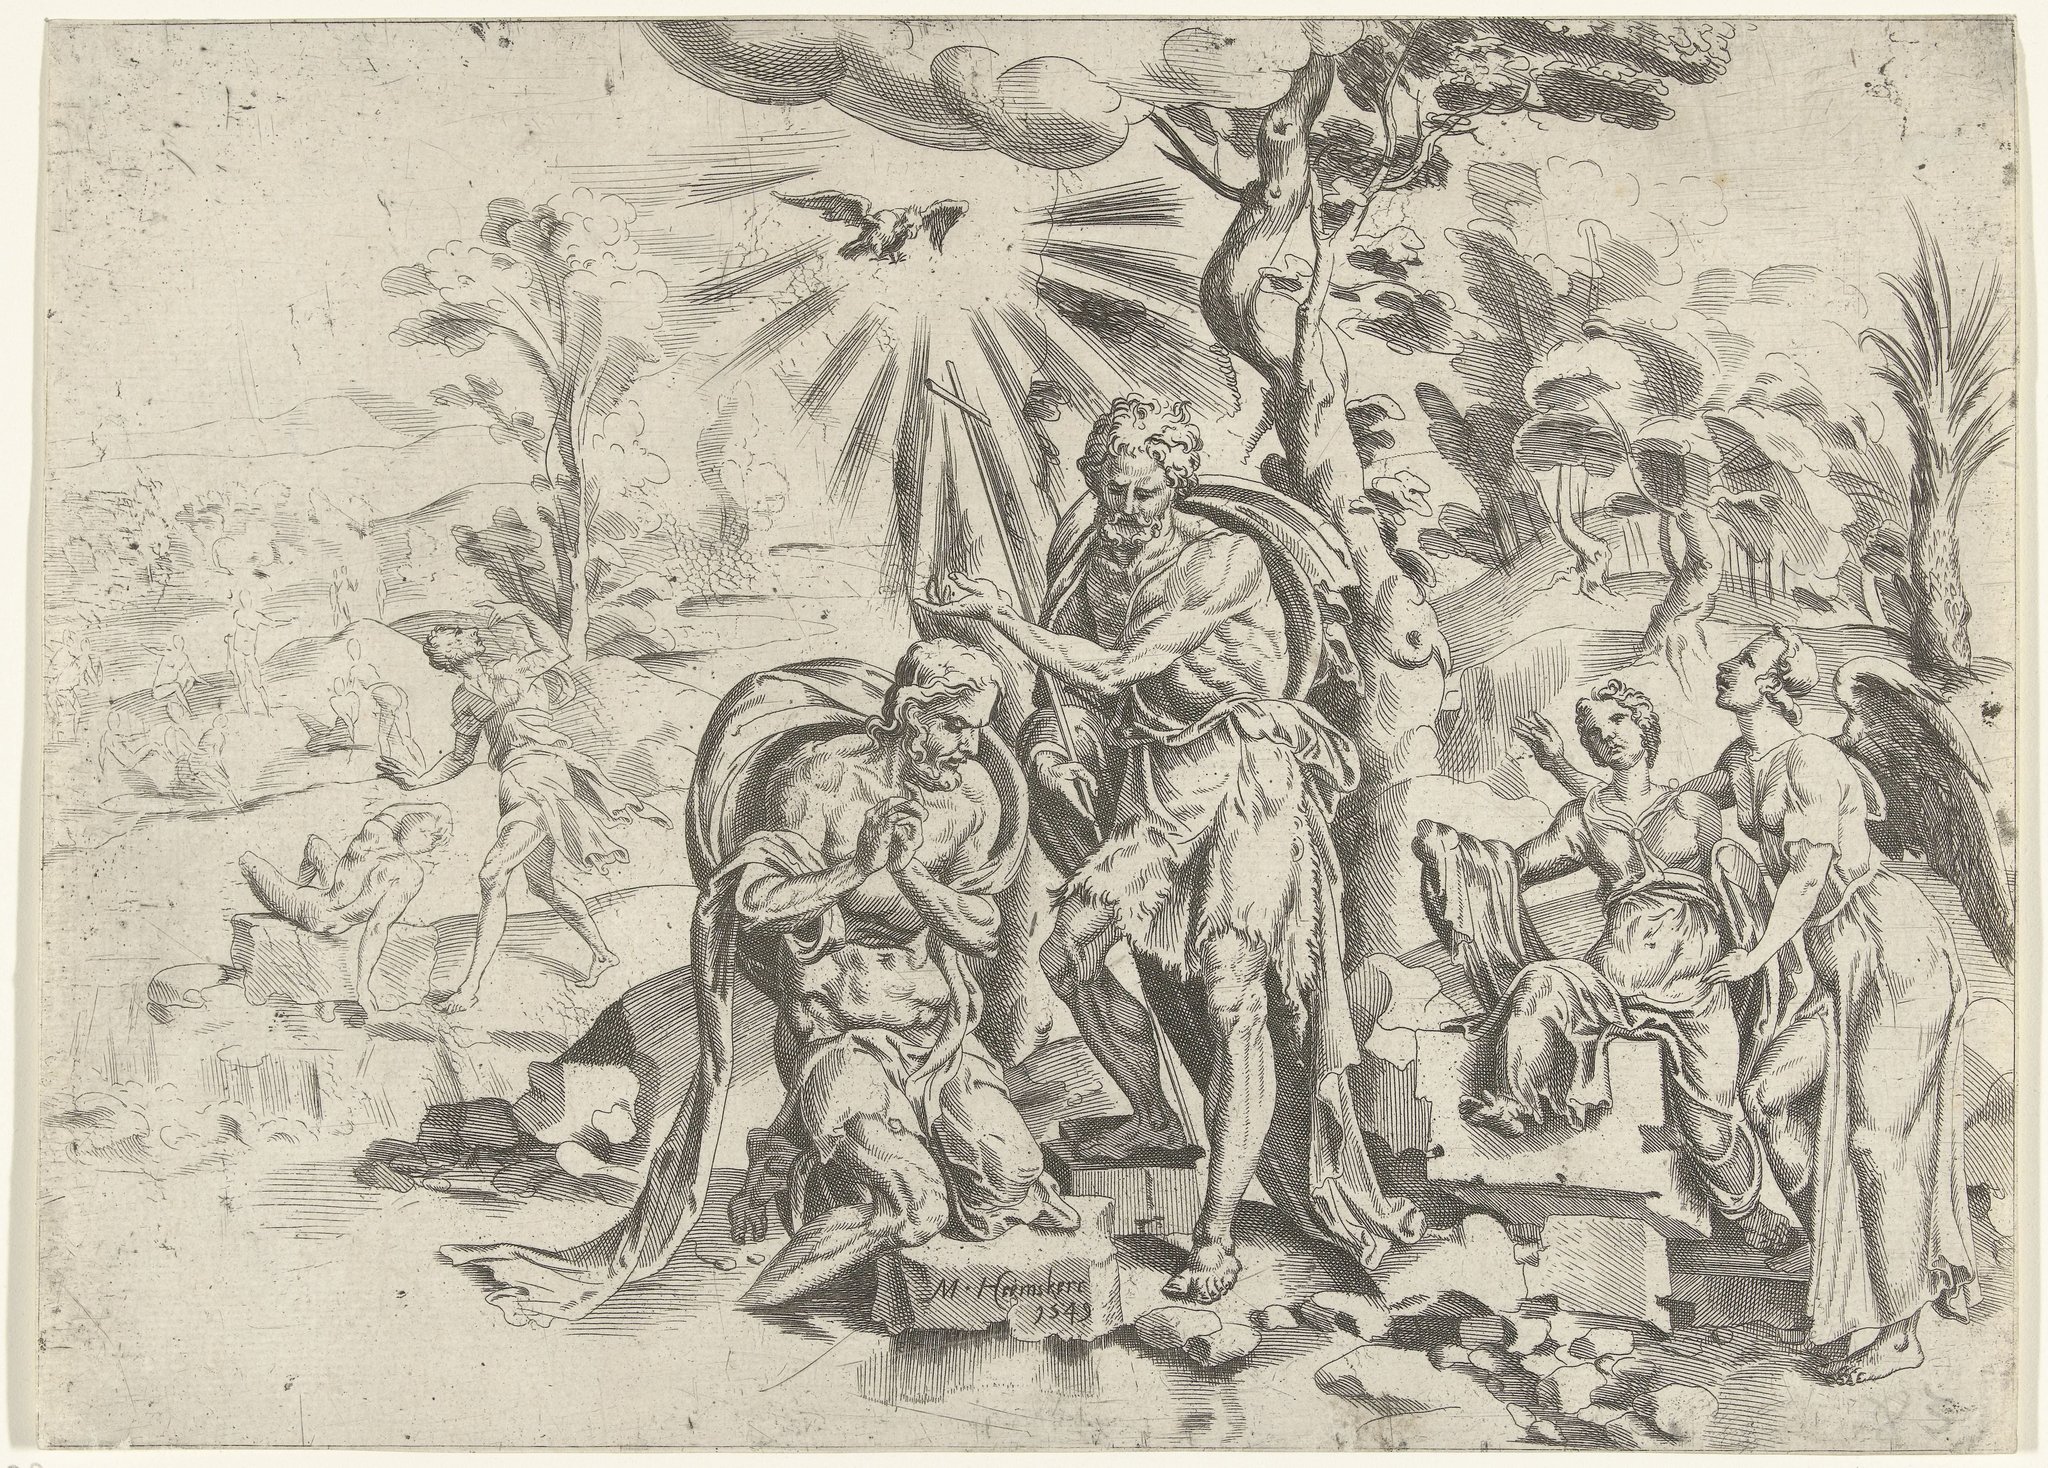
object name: print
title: Doop van Christus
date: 1549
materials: paper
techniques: etching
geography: haarlem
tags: baptism of christ in the river jordan: john the baptist pouring out water on christ's head: the holy ghost descends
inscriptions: collector's mark: Lugt 240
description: Christus wordt door Johannes de Doper in de Jordaan gedoopt. Boven hun hoofden de duif van de Heilige Geest. Engelen houden Christus' kleren vast op de oever.